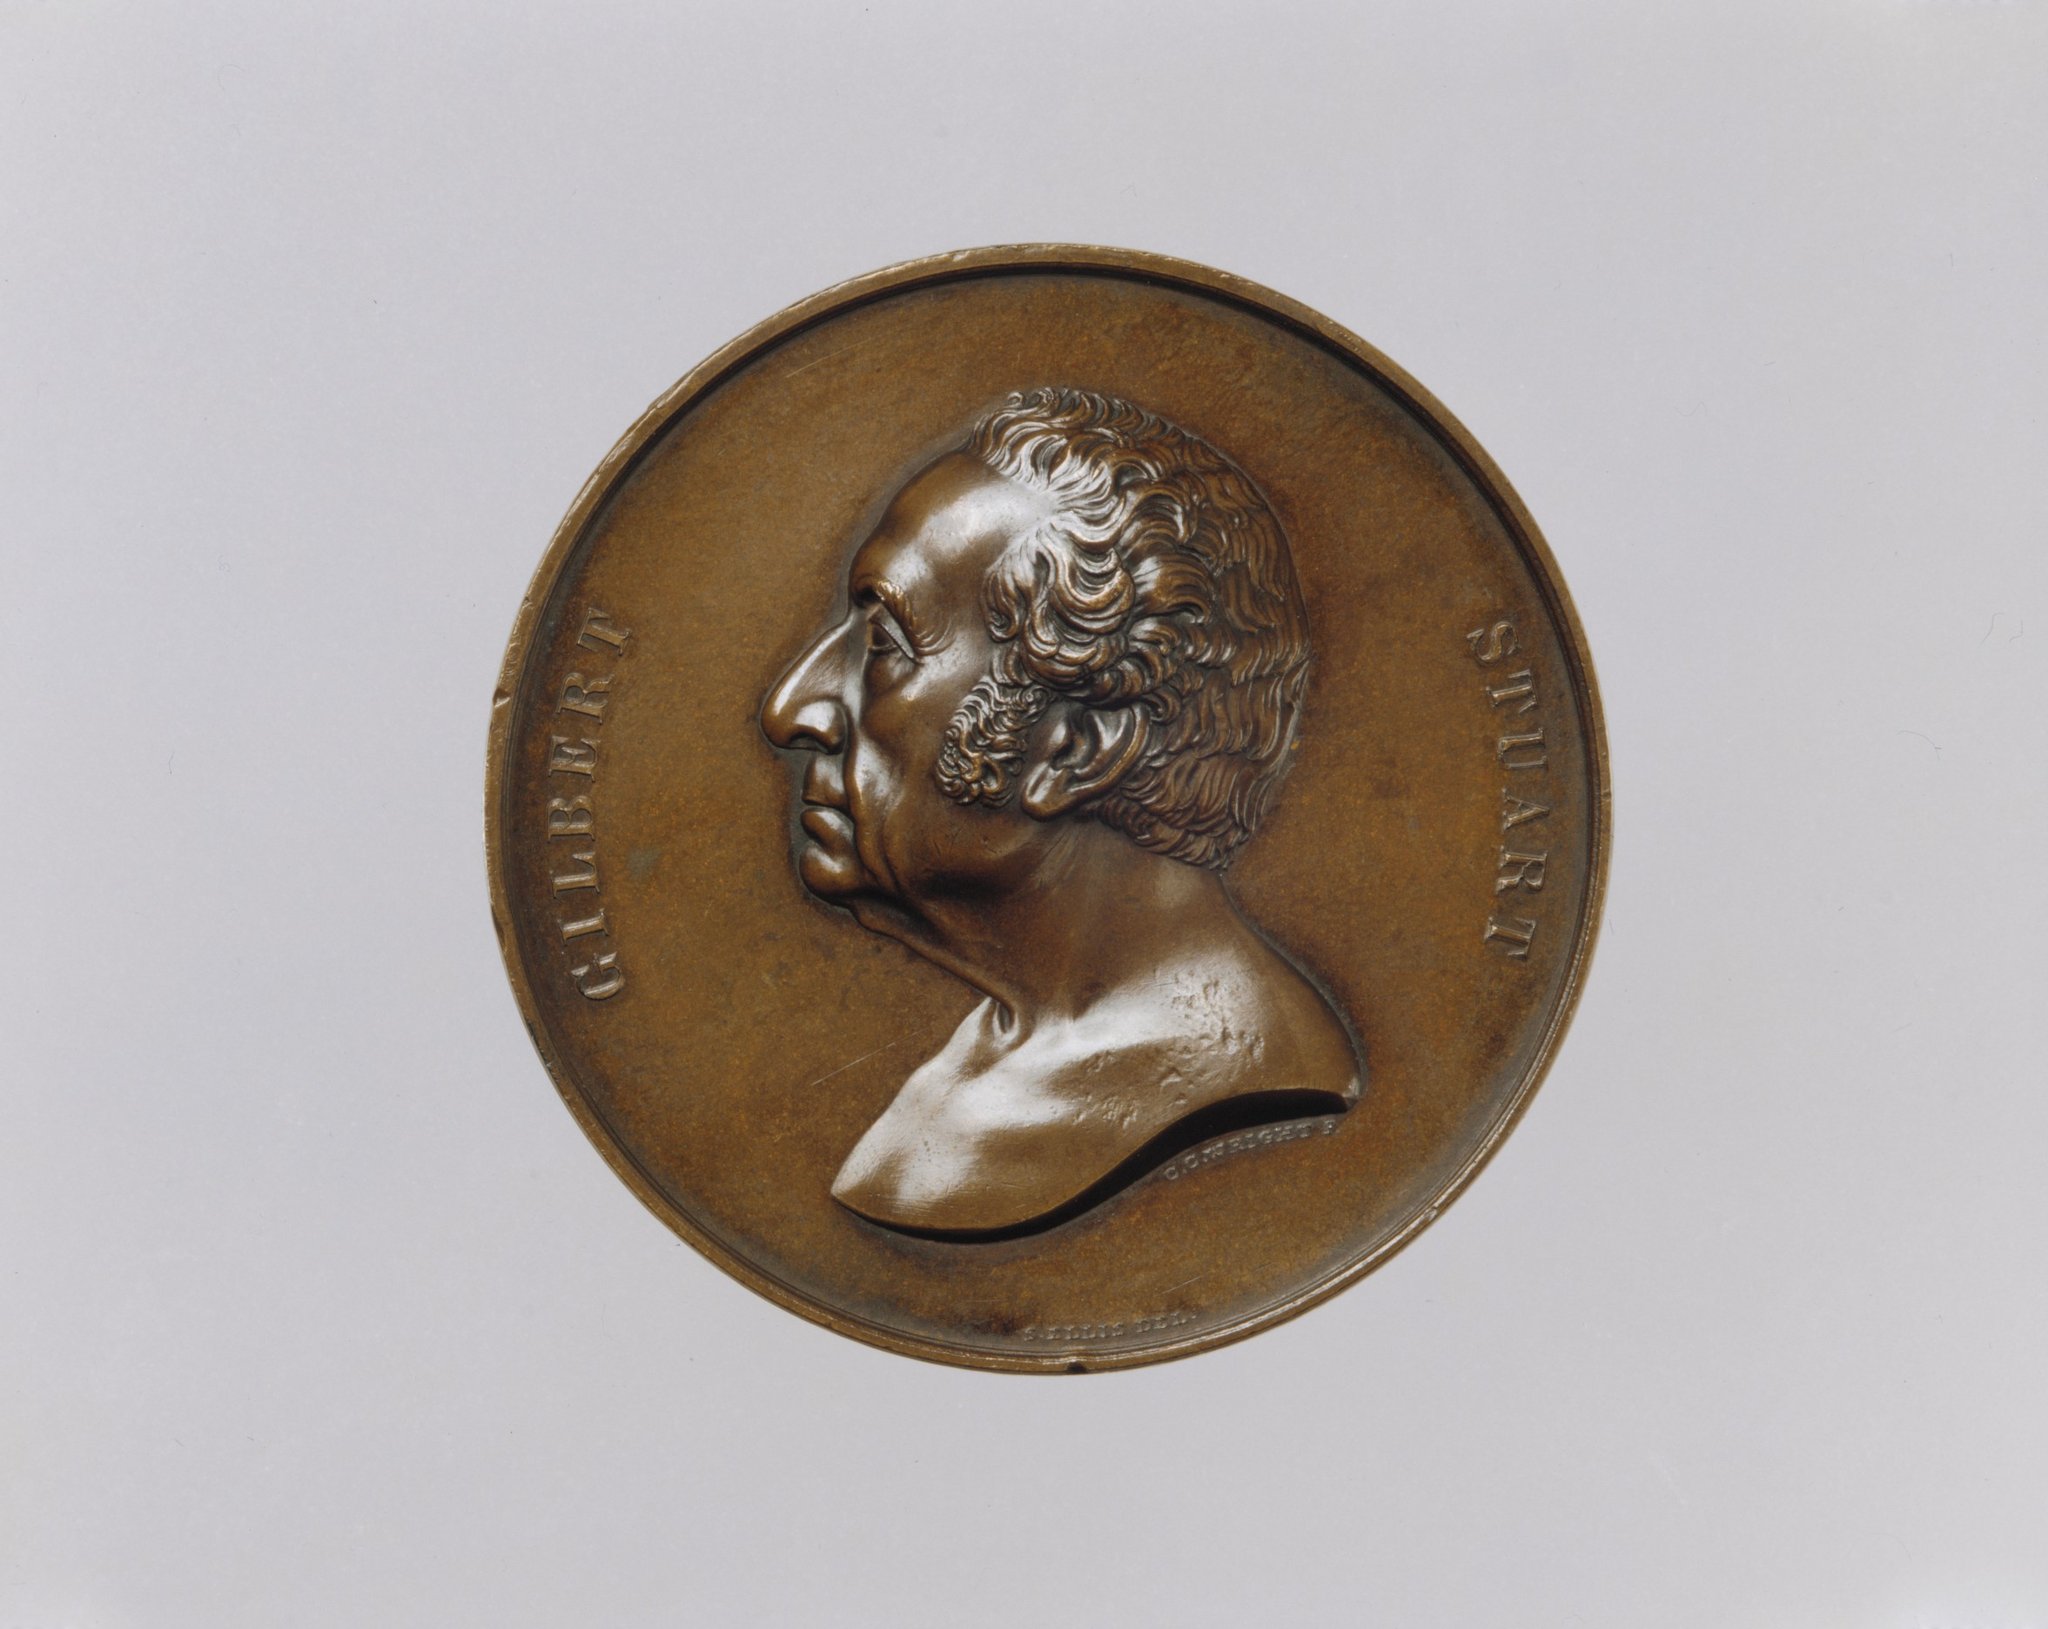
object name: medal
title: Gilbert Stuart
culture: american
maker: salathiel ellis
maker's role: artist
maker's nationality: american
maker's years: 1803-1879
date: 1848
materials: bronze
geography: united states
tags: men,profiles,women